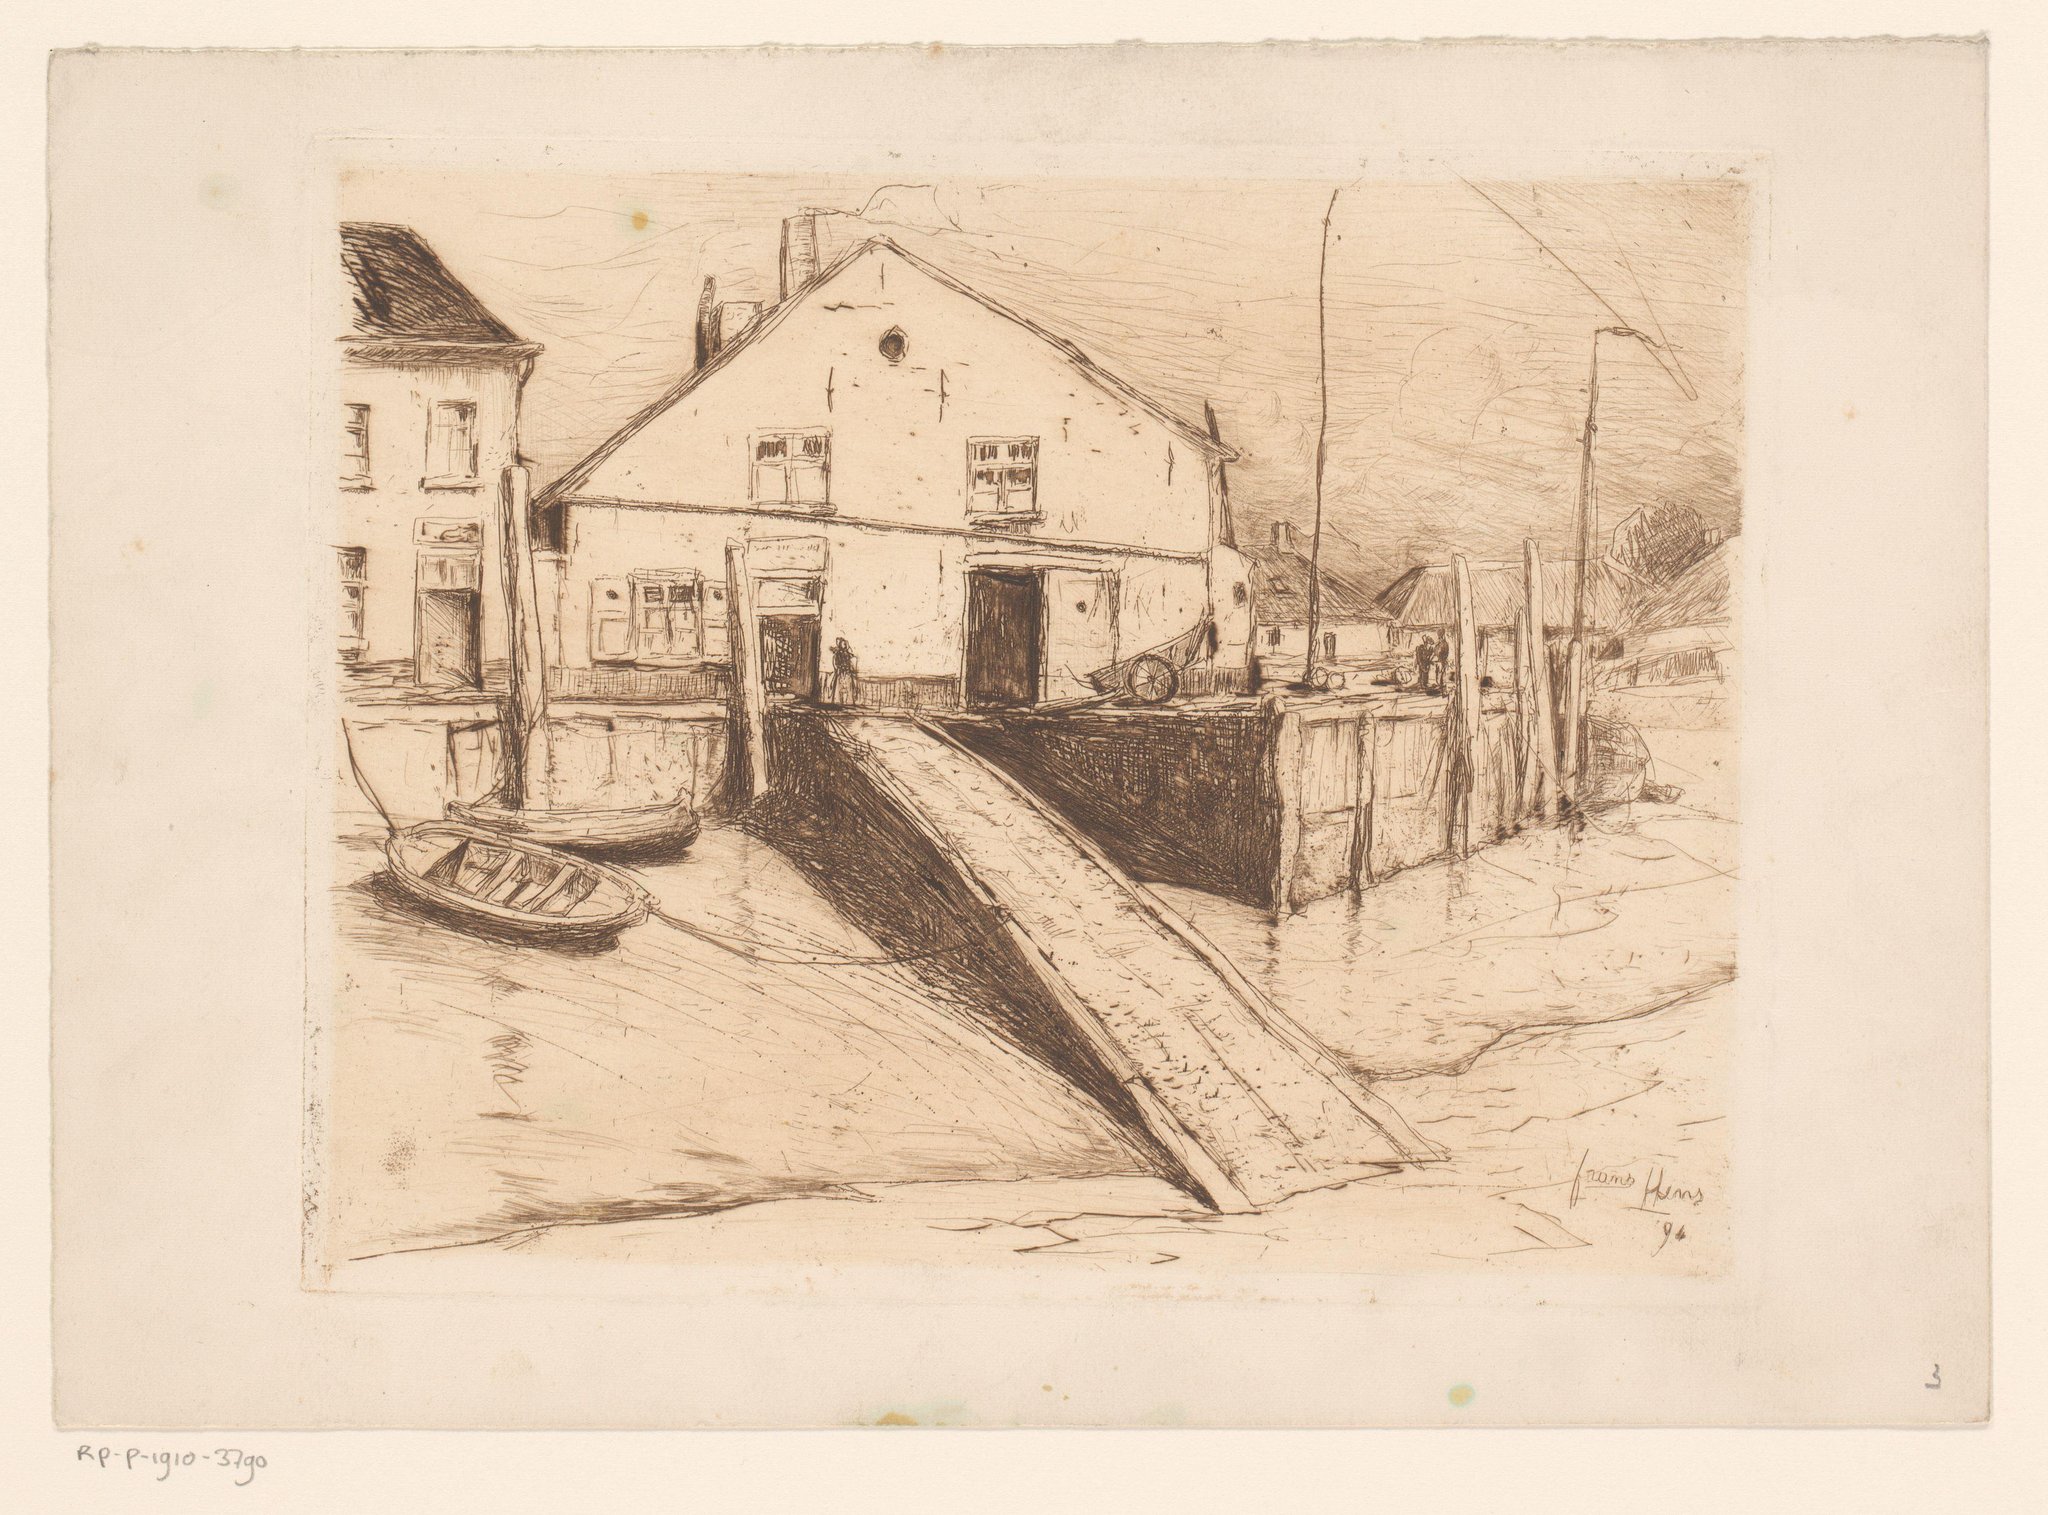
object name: print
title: Dorpshuizen langs de kade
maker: frans hens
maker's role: print maker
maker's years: 1856-1928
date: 1894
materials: paper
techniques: etching, intaglio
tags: landscapes with waters, waterscapes, seascapes (in the temperate zone), pier, quay, wharf, boat propelled by man or animal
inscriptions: collector's mark: Lugt 2228